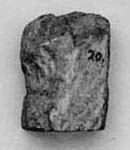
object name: fragment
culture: burmese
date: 1902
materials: jade